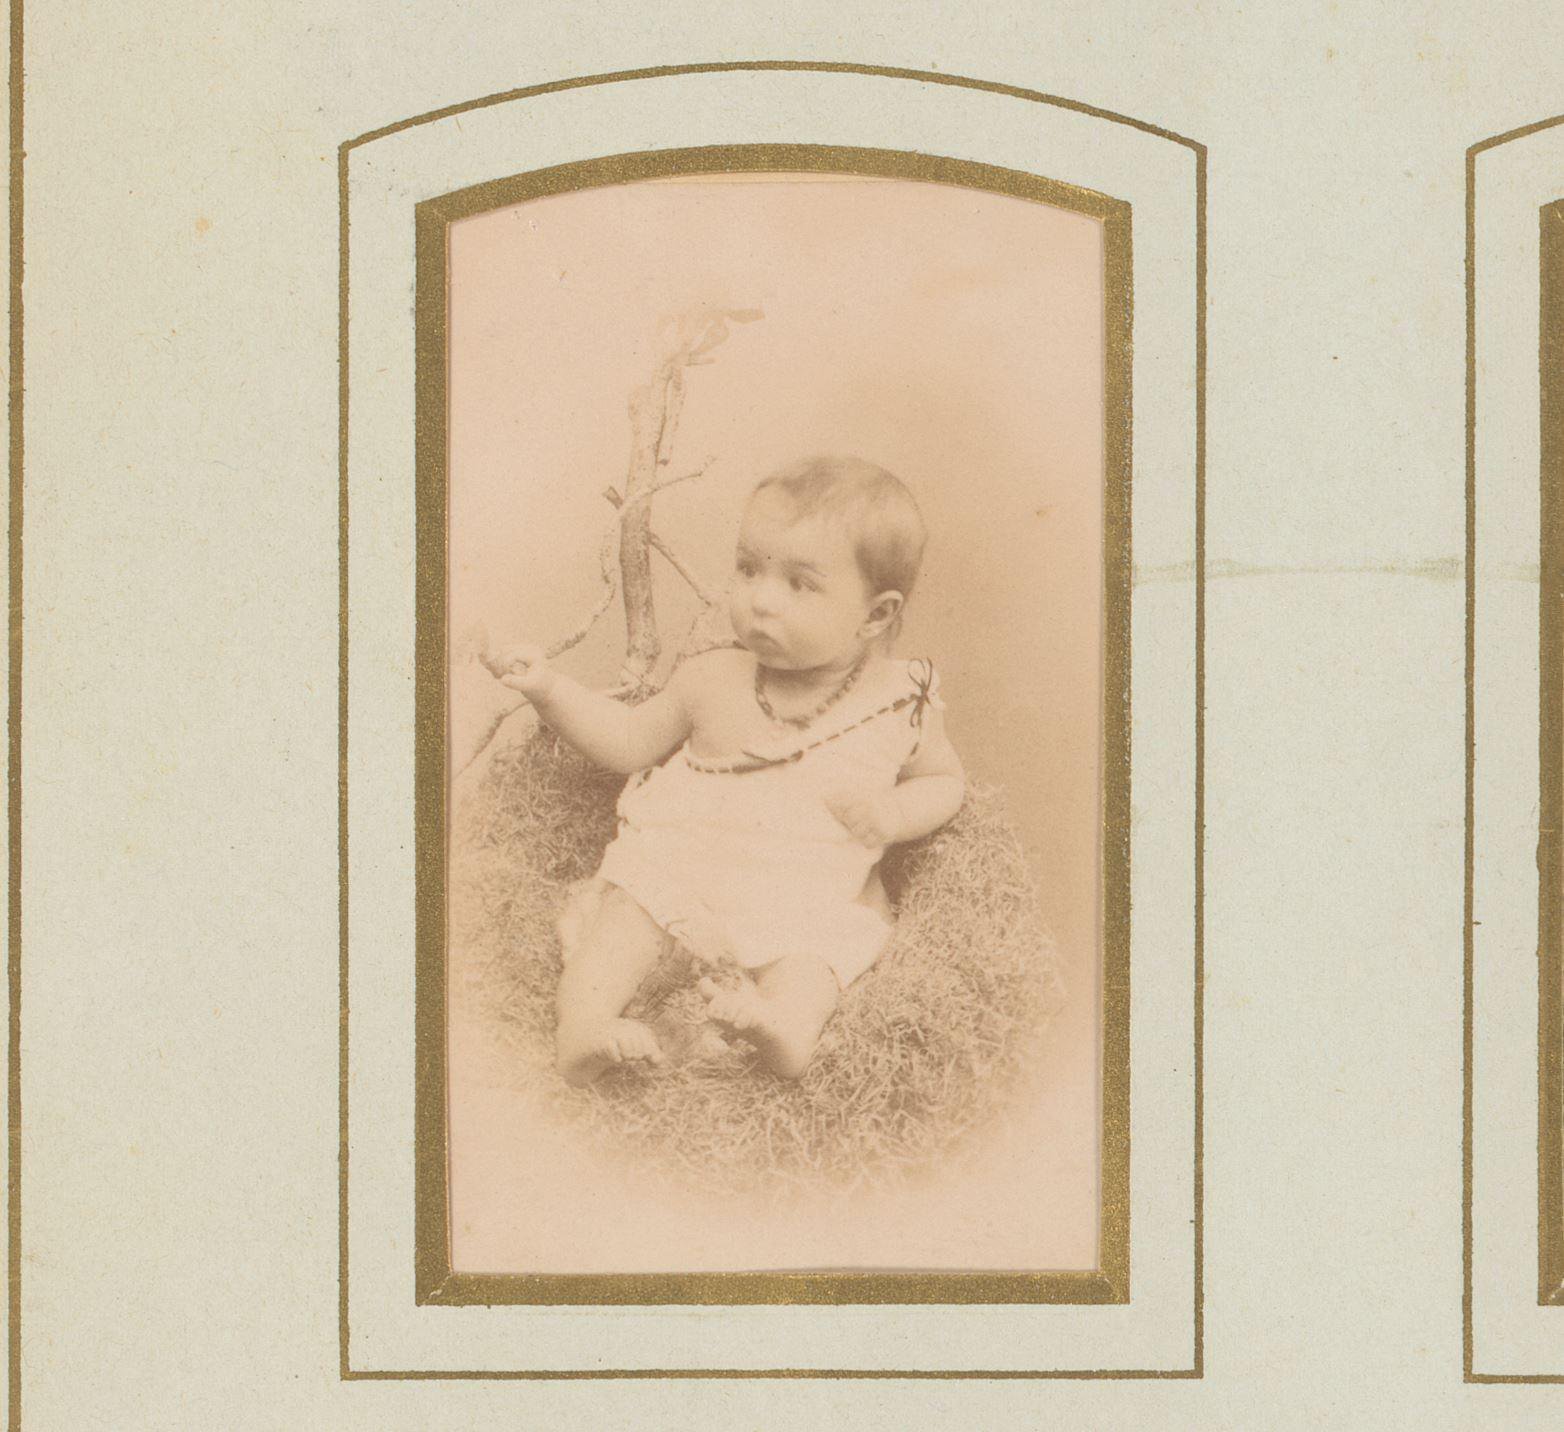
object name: carte de visite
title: Portret van een baby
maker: jules beau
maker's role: fotograaf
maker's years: 1864-1932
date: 1874-1900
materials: cardboard, photographic support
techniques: albumen print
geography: paris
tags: historical persons, infant, baby ~ the ages of man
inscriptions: inscription: ‘Photographie/ de Passy/ M H Fontès/ Jules Beau/ Succ(...)/ 51/ Rue de Passy/ Paris’